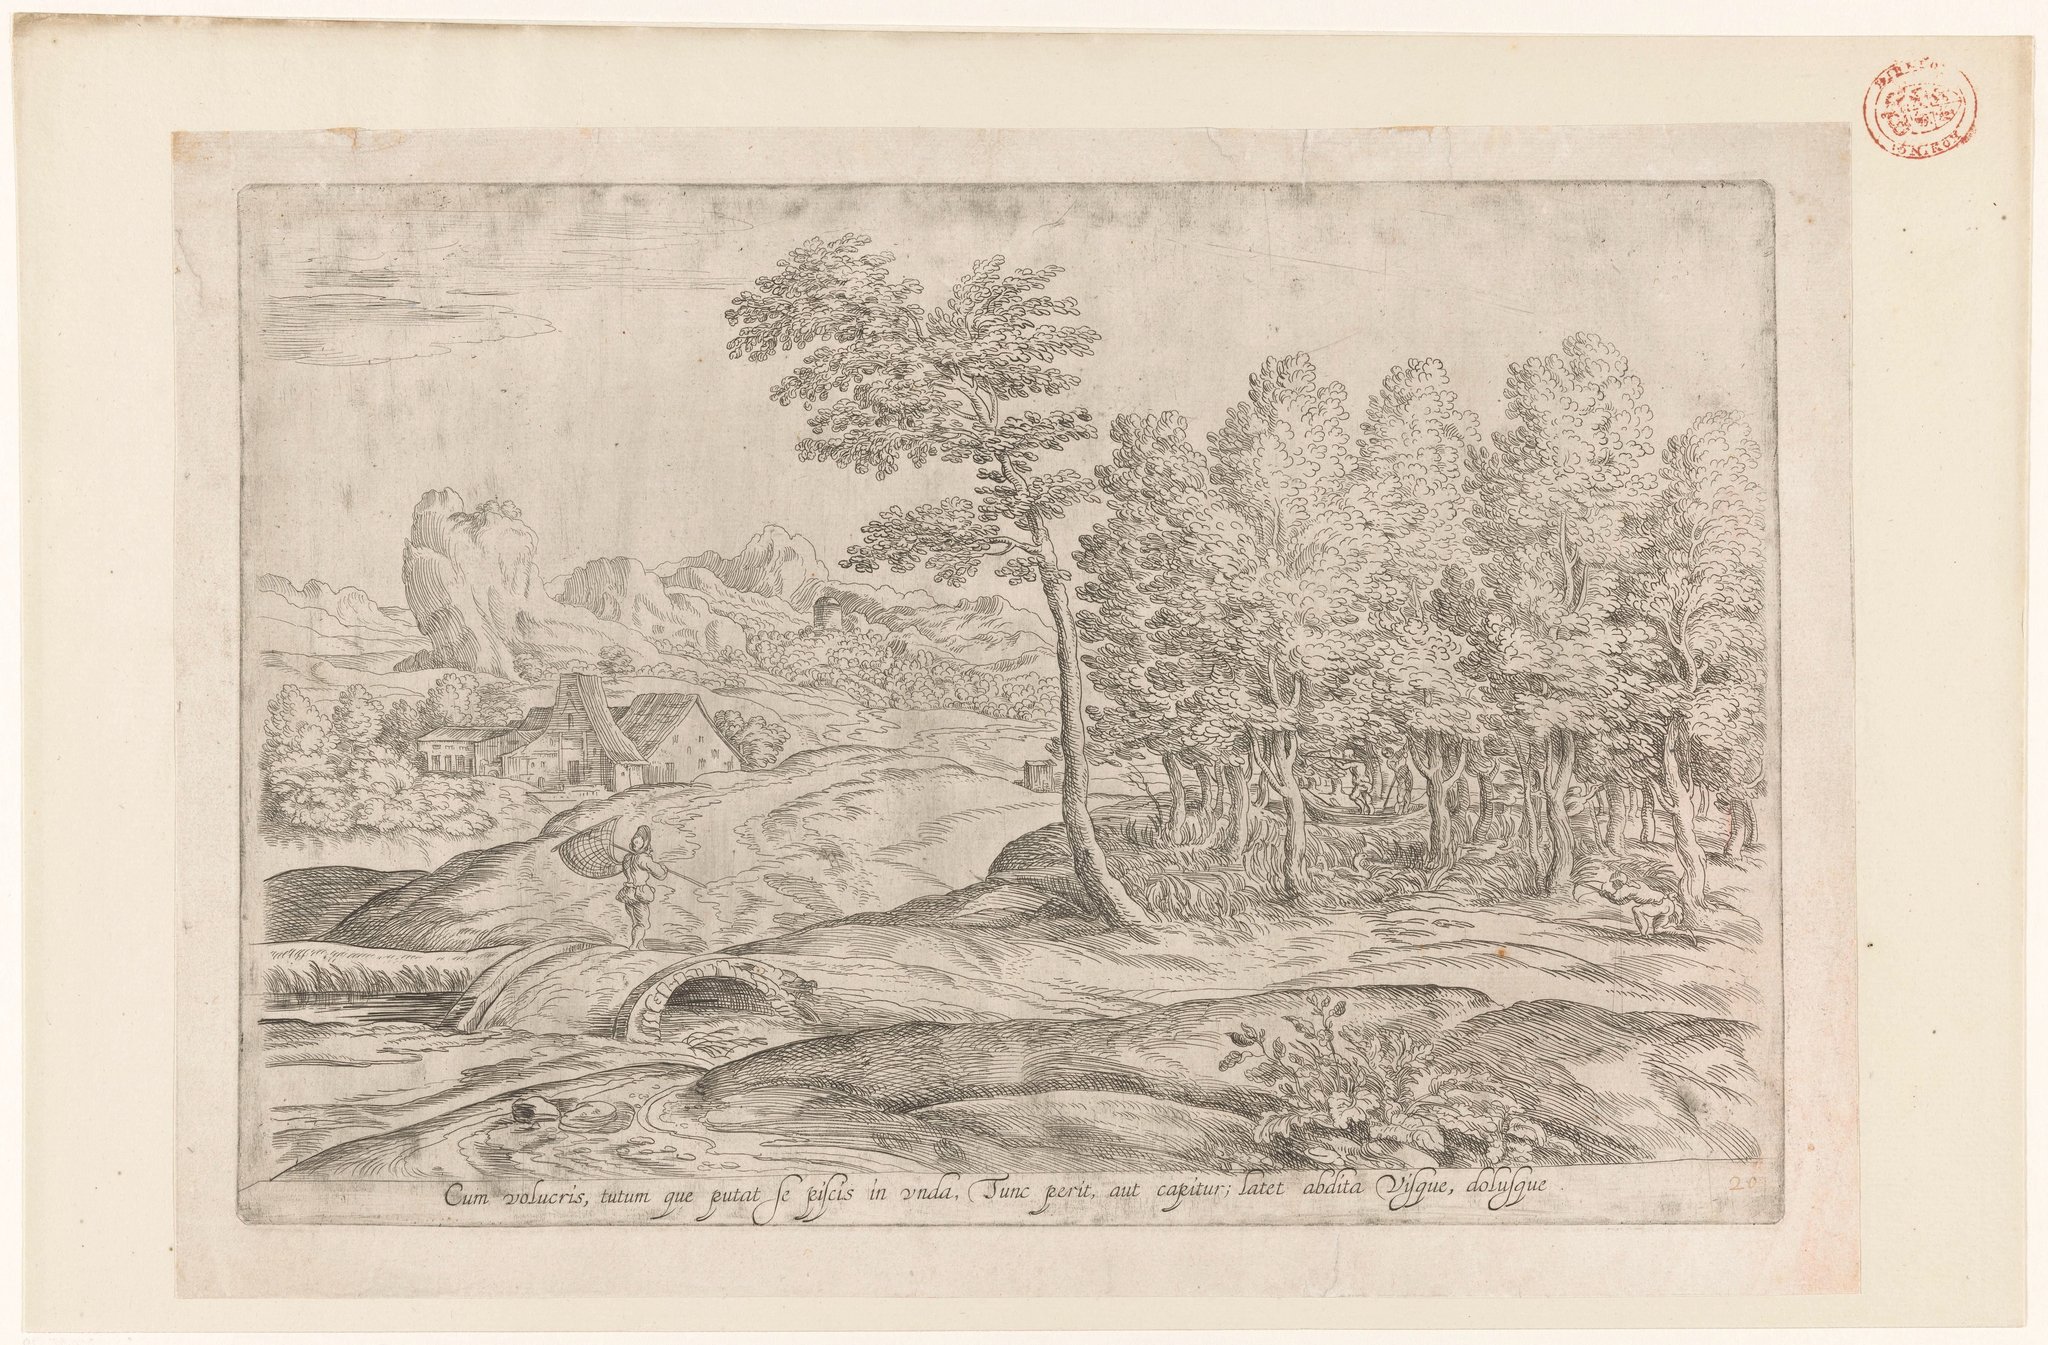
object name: print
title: Cum volucris, tutum que putat se piscis in unda, tunc perit, aut capitur; latet abdita Visque, dolusque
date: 1600-1699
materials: paper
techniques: etching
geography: italy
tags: landscapes, fishing net, fisherman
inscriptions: collector's mark: Lugt 2228, collector's mark: Lugt 240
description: Landschap met op de voorgrond links een brug over een stroom en een visser met een net. Rechts tussen de bomen jagers die op watervogels jagen. Titel in het Latijn in ondermarge. Genummerd rechtsonder: 20.